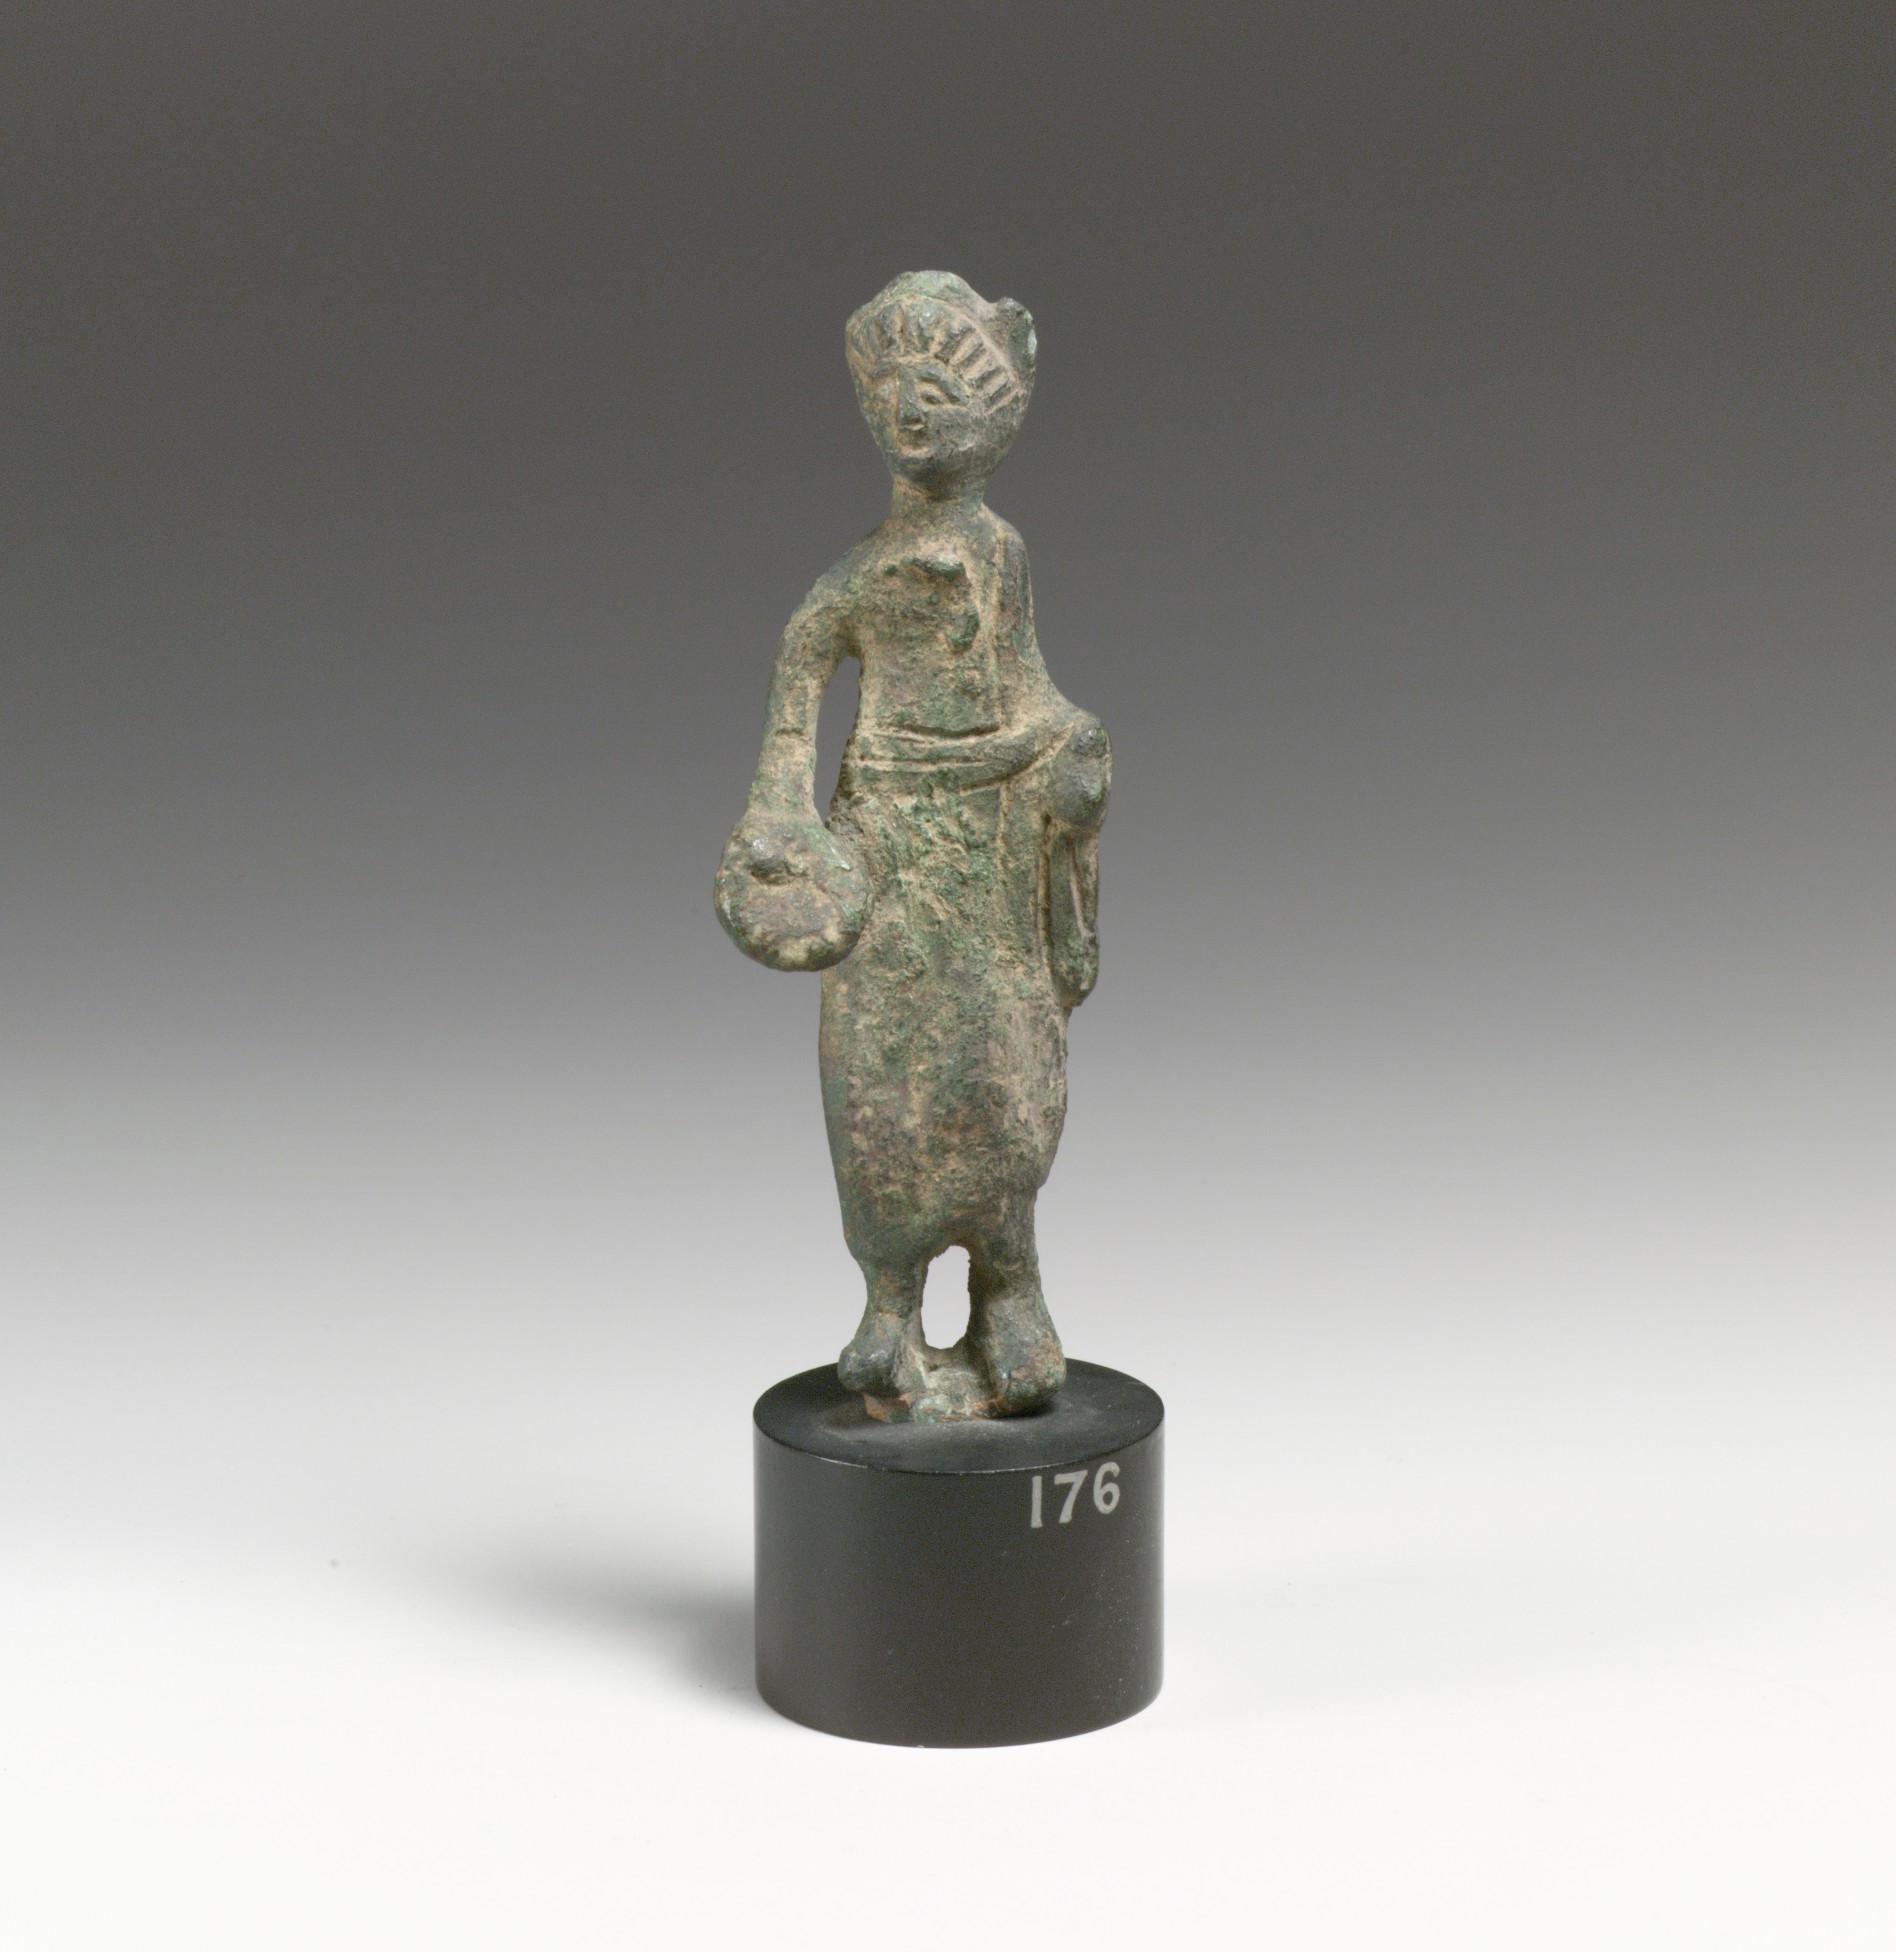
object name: statuette of a man with vessel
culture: etruscan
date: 300-1 BCE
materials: bronze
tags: men